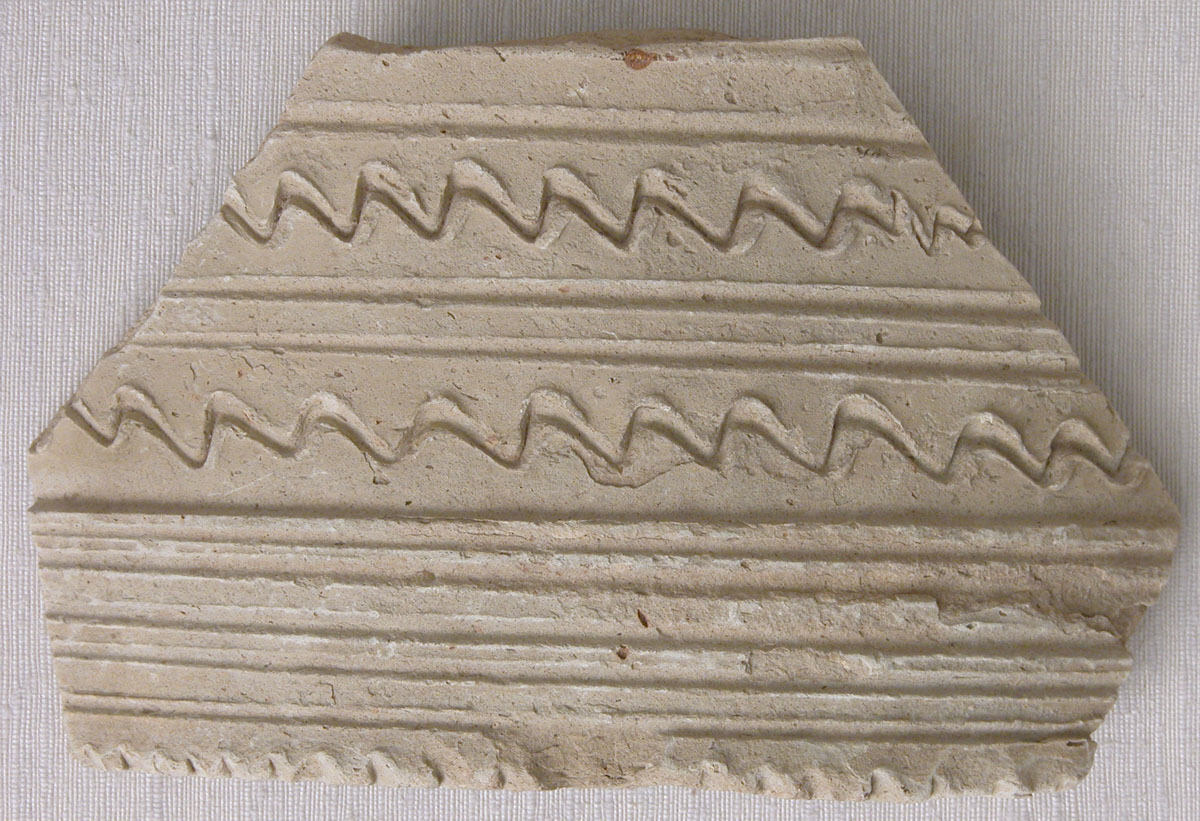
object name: fragment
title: Ceramic Fragment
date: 701-900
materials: earthenware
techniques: incising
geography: iraq